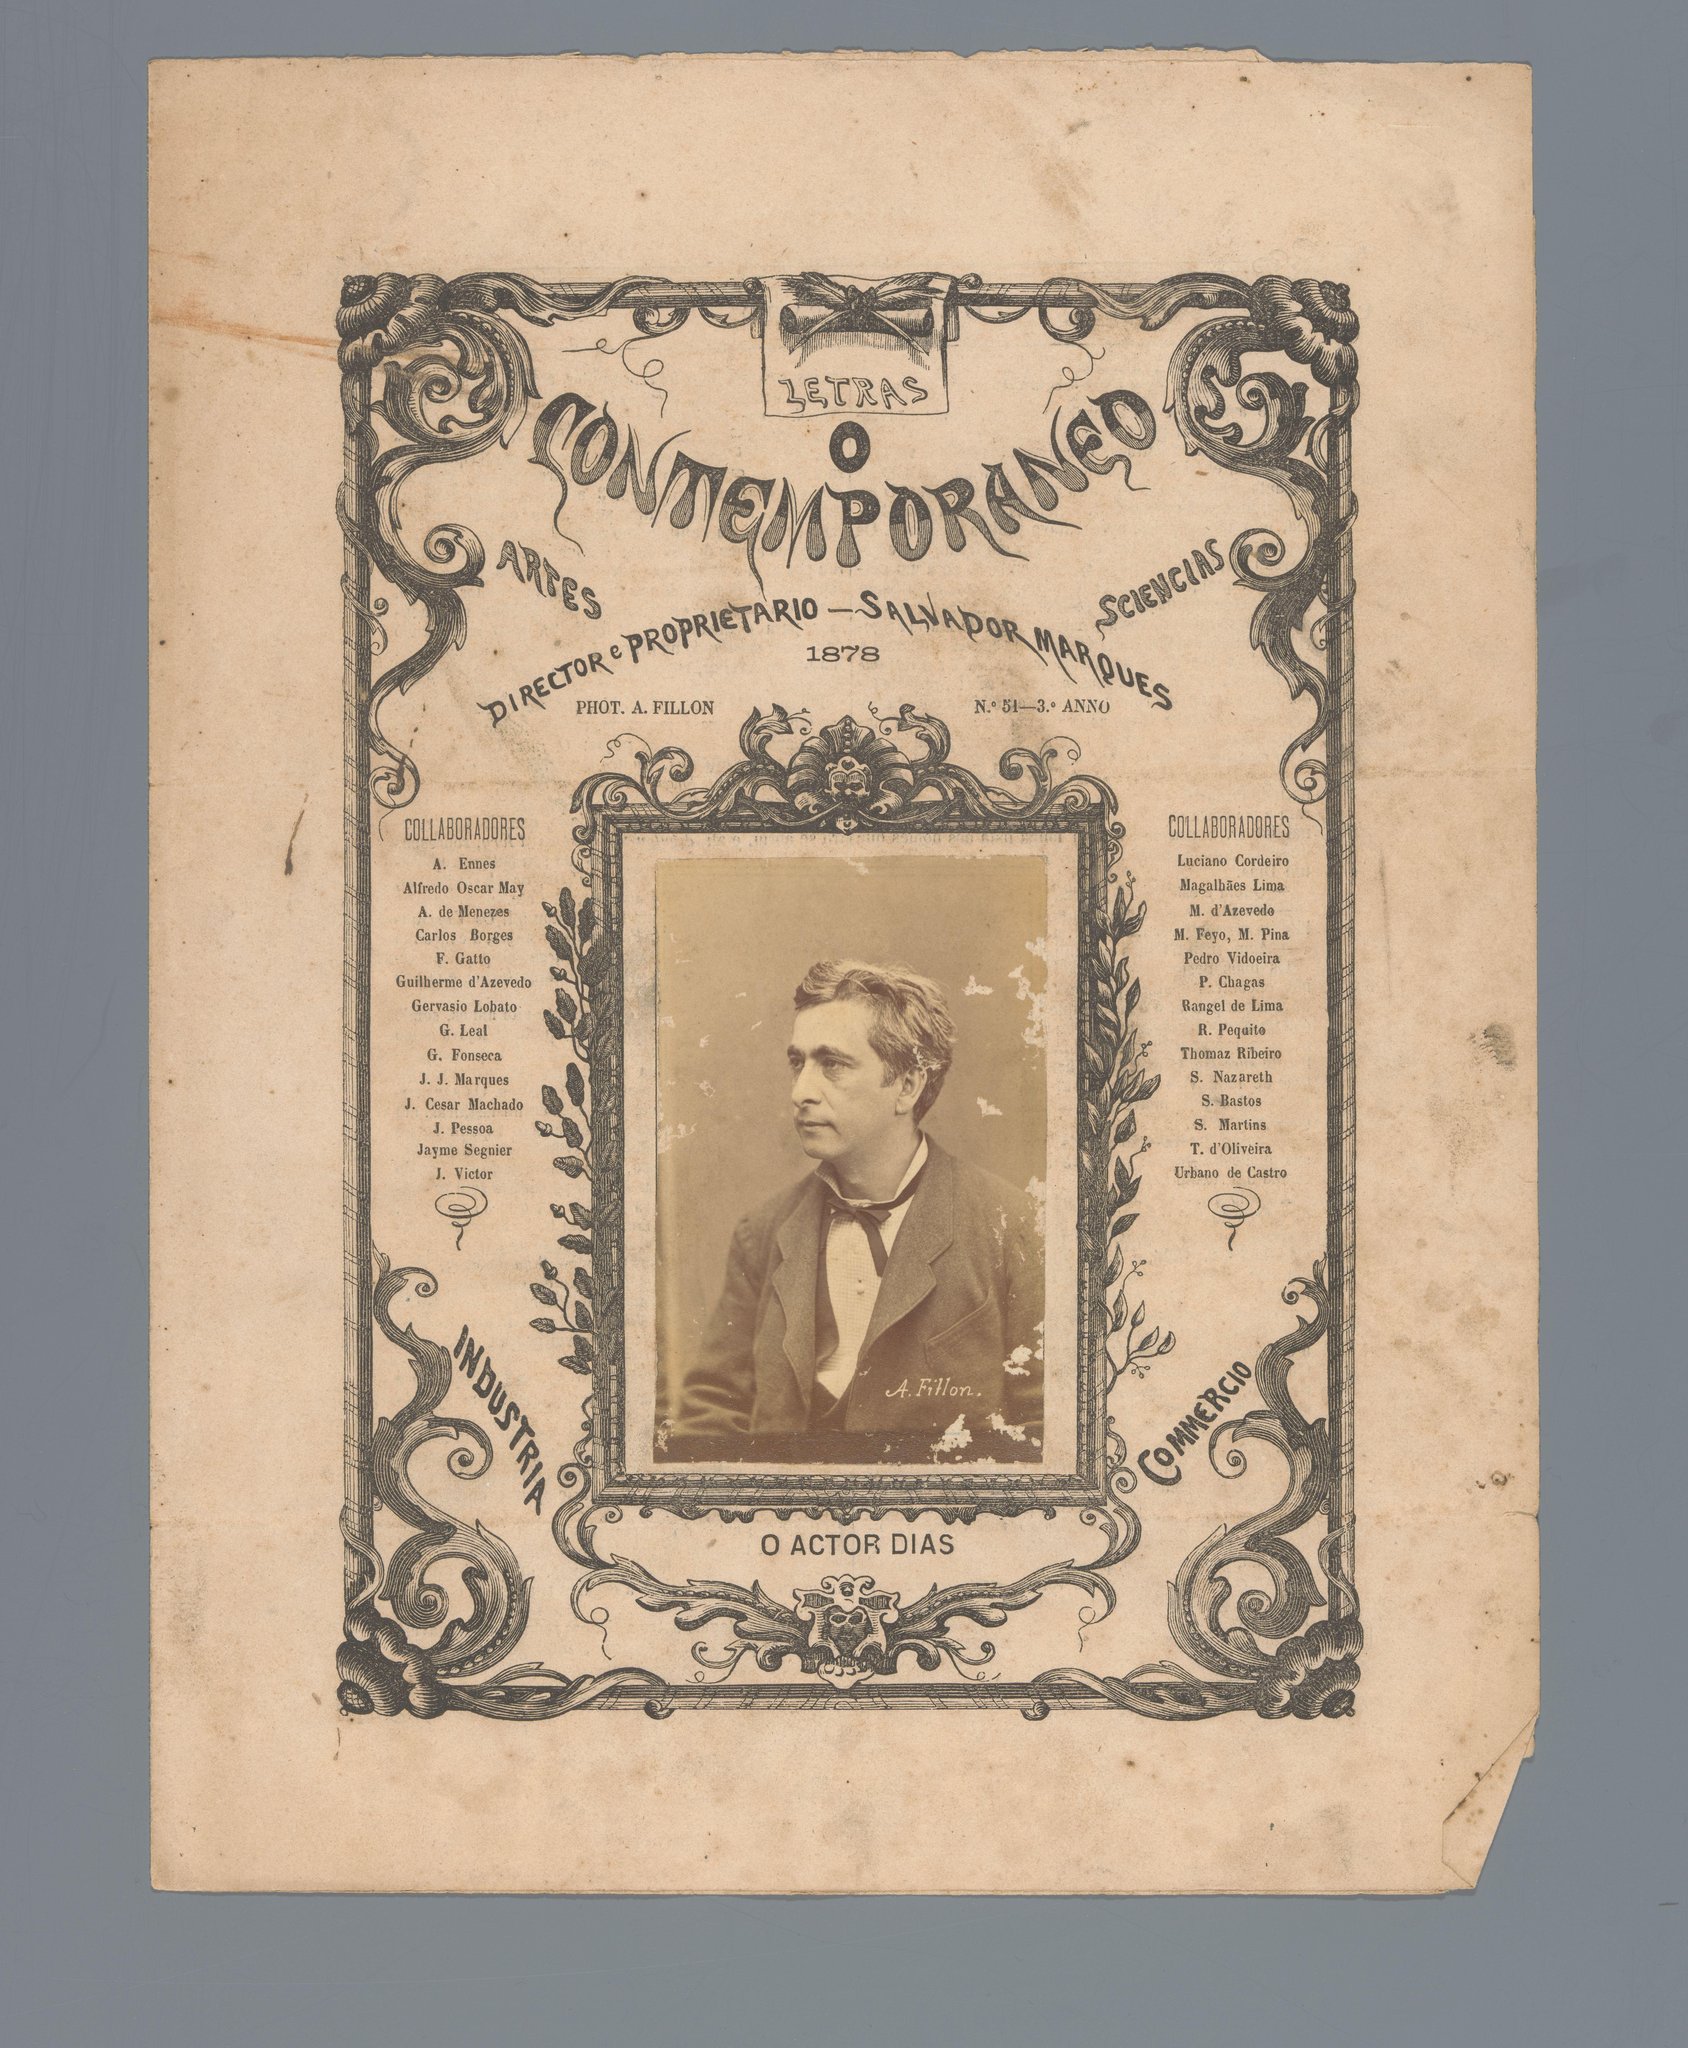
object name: photograph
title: O contemporaneo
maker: alfred fillon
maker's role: fotograaf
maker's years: 1825-1881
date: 1873-1878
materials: paper, photographic support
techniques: albumen print, printing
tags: historical persons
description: Op de voorpagina bevindt zich een portret van een onbekende man.